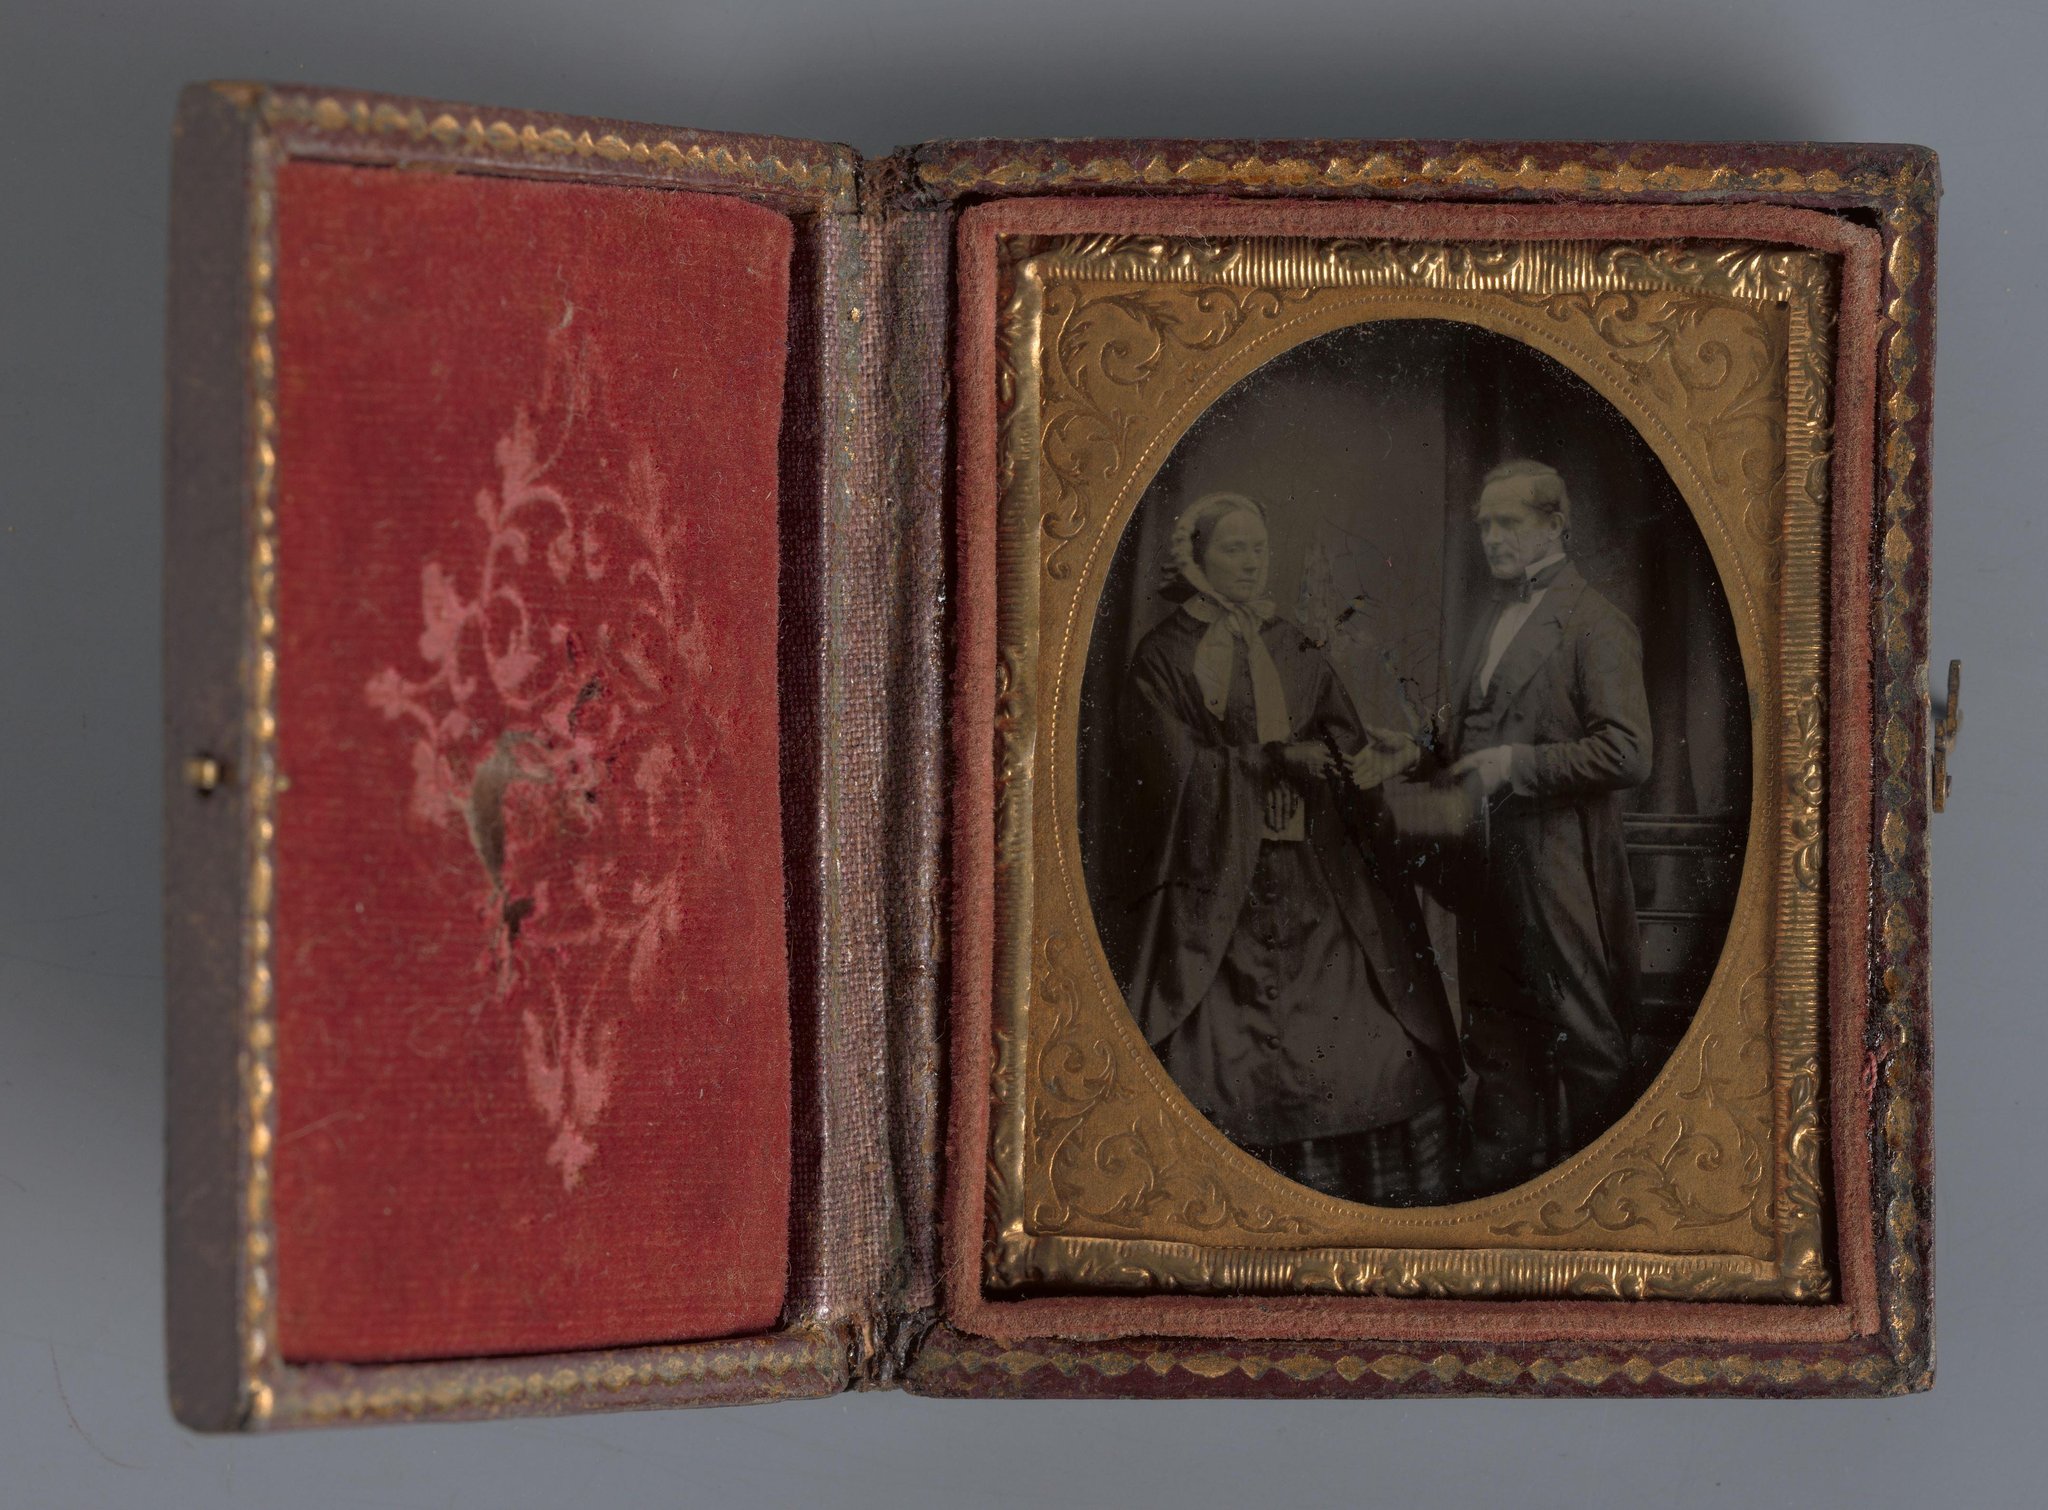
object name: photograph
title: Portret van een onbekend echtpaar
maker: Anonymous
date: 1855-1870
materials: glass, leather, metal, velvet, wood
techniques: ambrotype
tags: historical persons - bb - woman, historical persons, marriage, married couple, 'matrimonium'